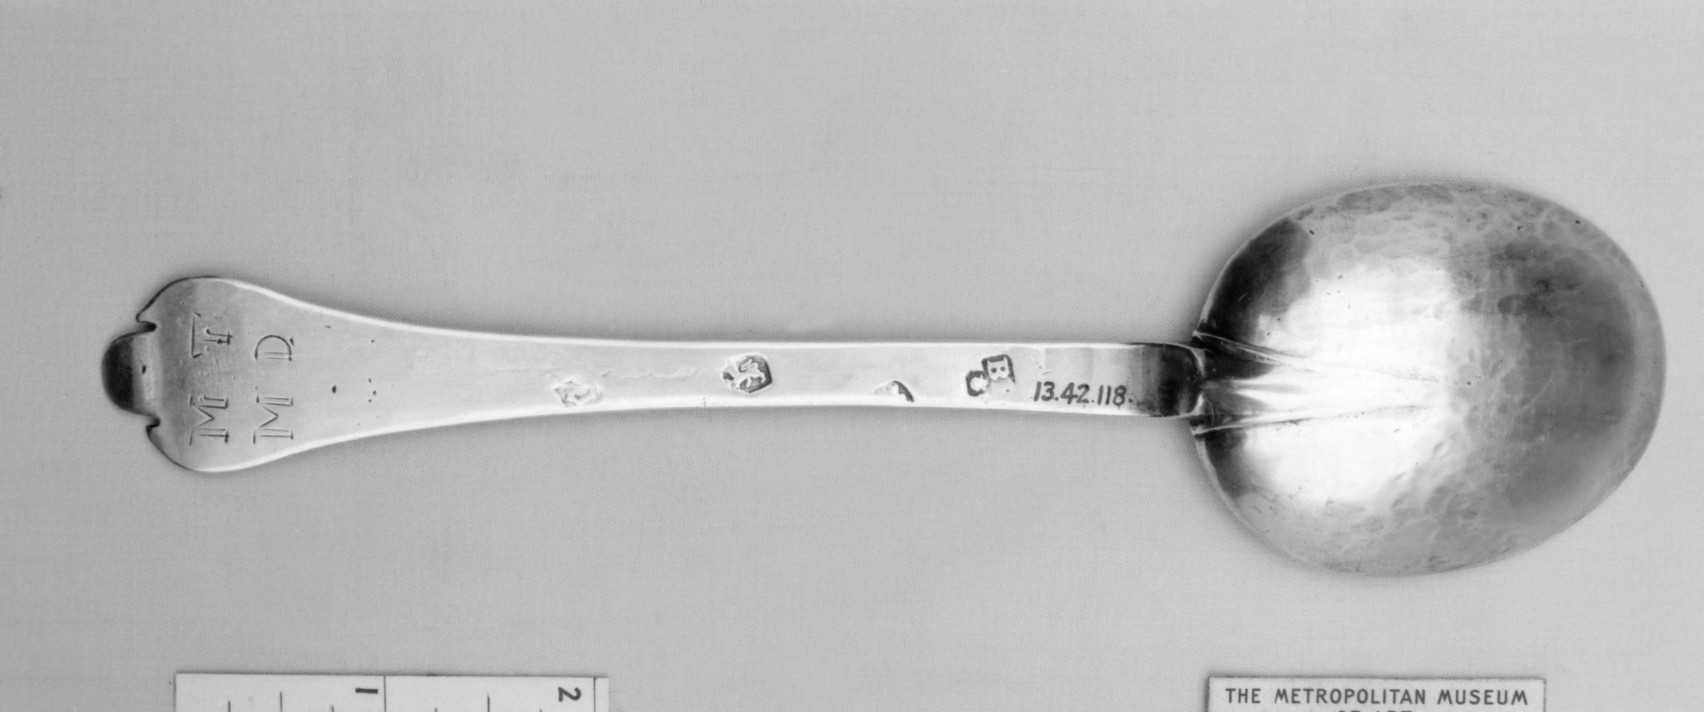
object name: spoon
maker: benjamin prosser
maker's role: maker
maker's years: 1667-1680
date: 1680-1681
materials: silver